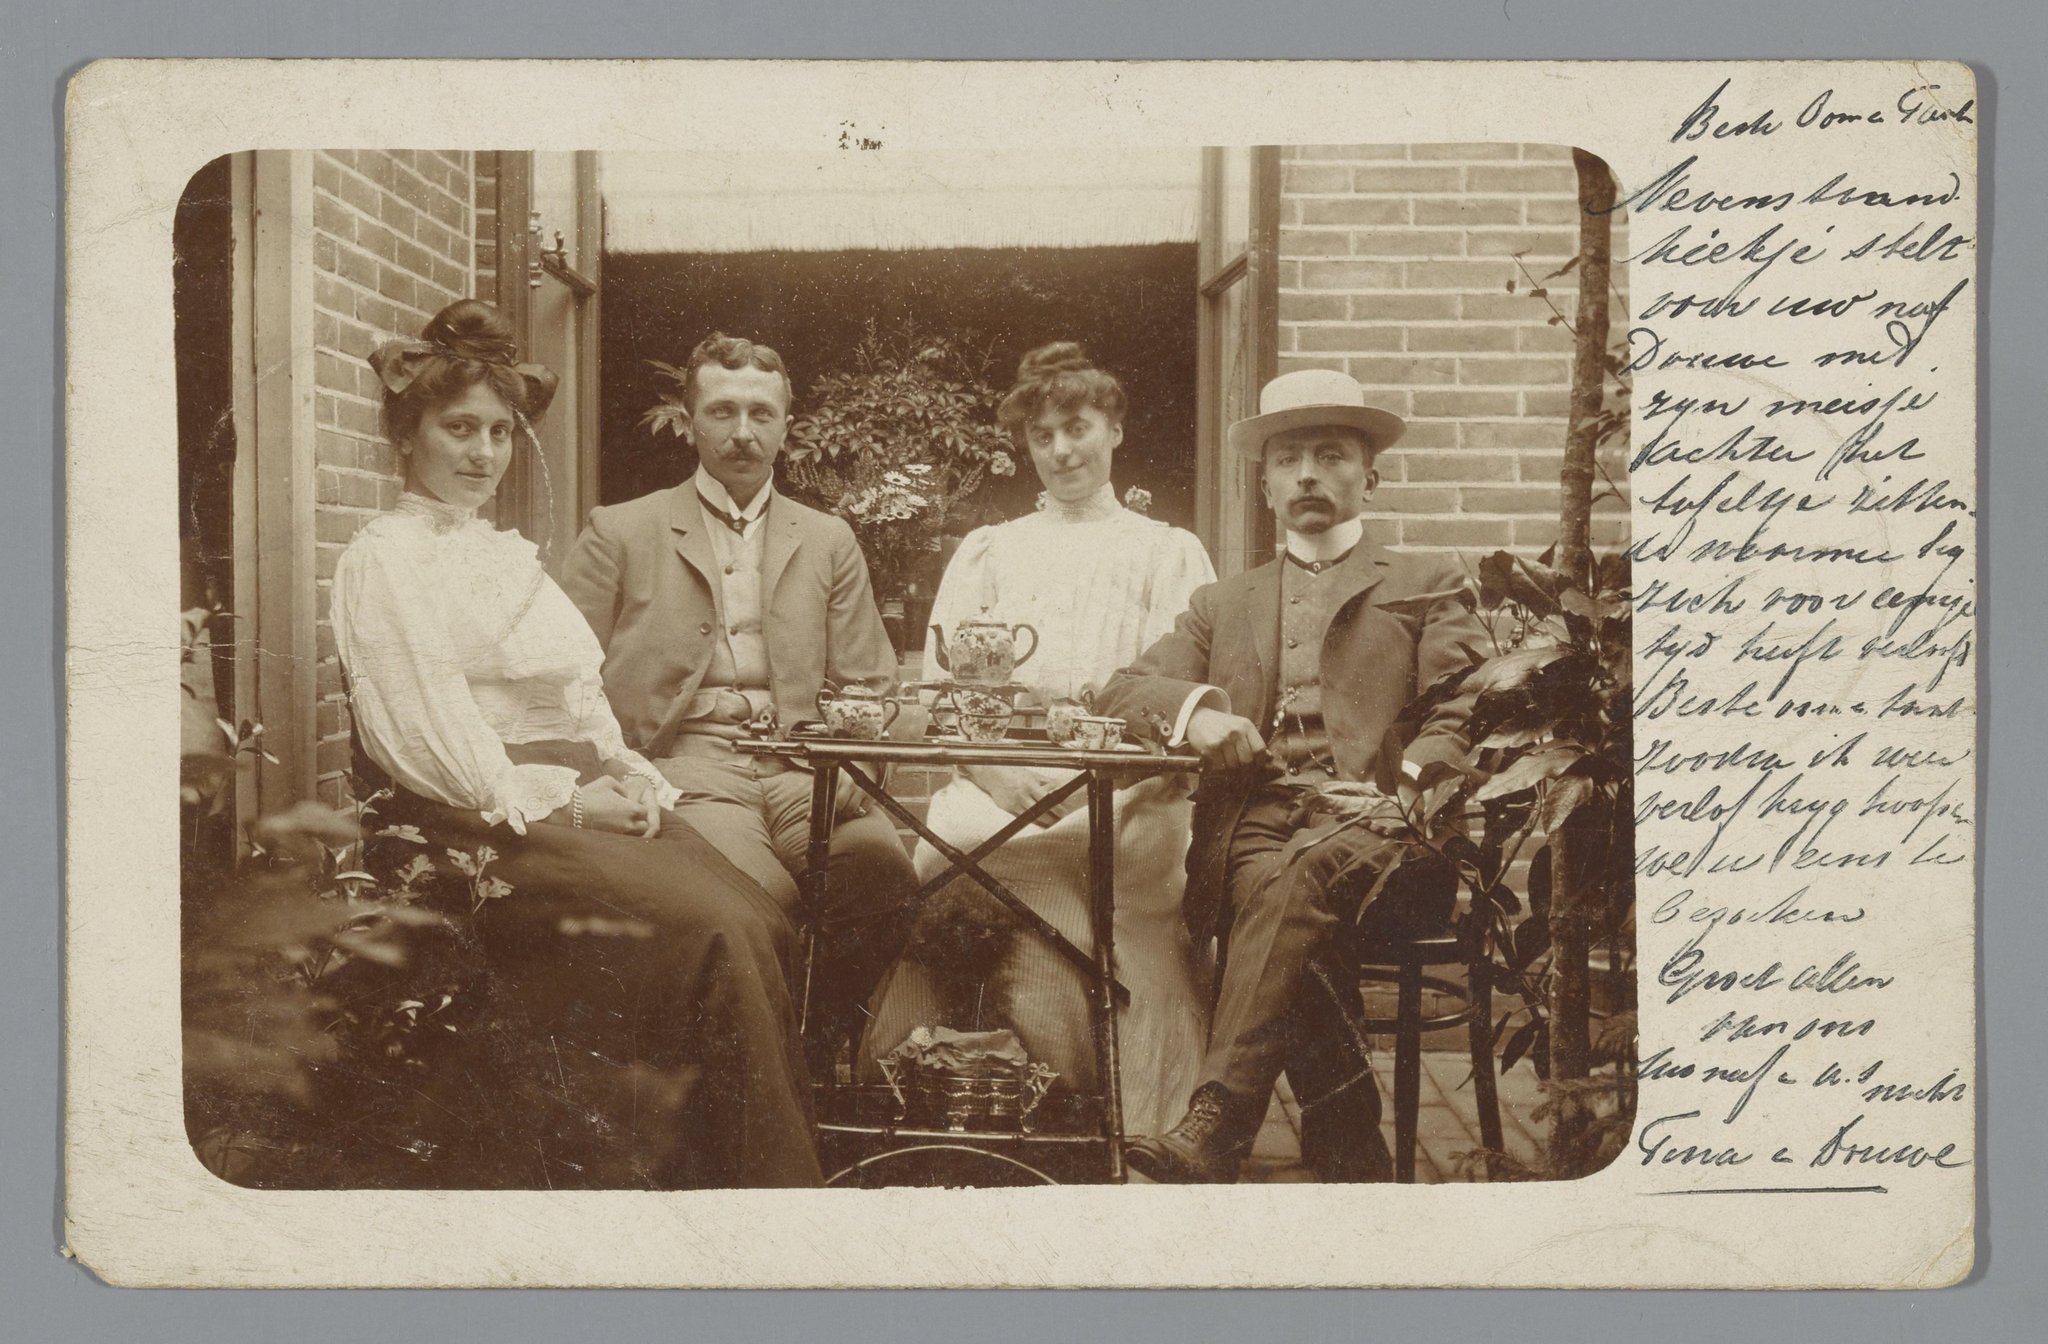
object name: ansichtkaart, prentbriefkaart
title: Portret van twee jonge stellen achter een tafel in een tuin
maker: Anonymous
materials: photographic support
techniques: gelatin silver print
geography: netherlands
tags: garden, table, couple of lovers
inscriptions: inscription: ‘Den Heer H. Hensten [...] Sneek’, inscription: ‘Beste Oom & Tante, Nevens (...) Tina & Douwe’